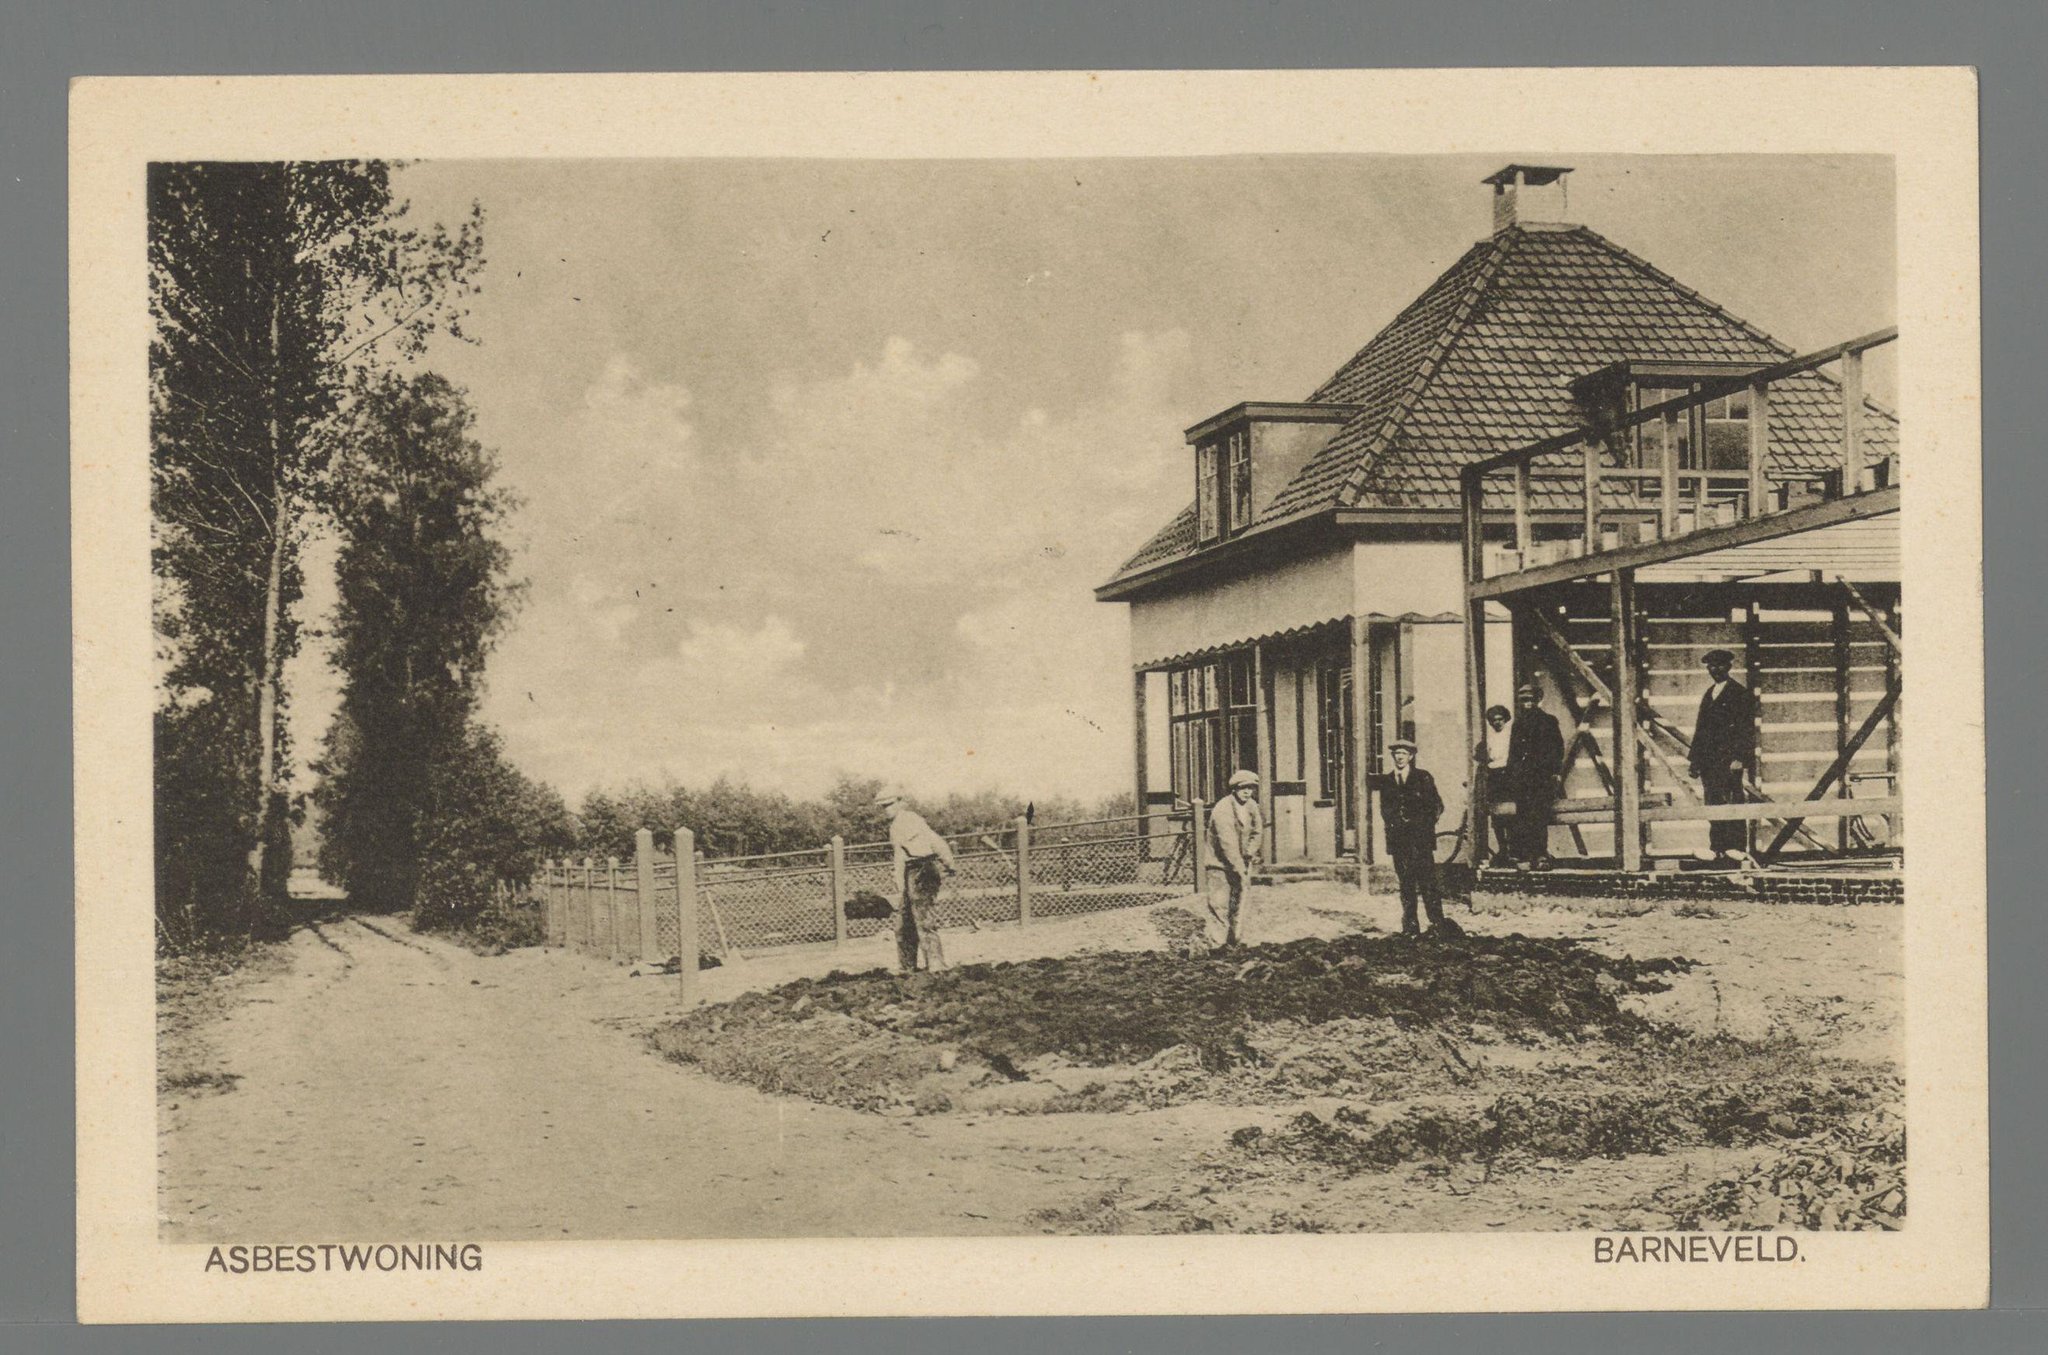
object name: ansichtkaart, prentbriefkaart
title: Asbestwoning. Barneveld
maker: Anonymous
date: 1913-1930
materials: cardboard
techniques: photograph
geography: barneveld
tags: ruin of a dwelling, house, castle, etc.